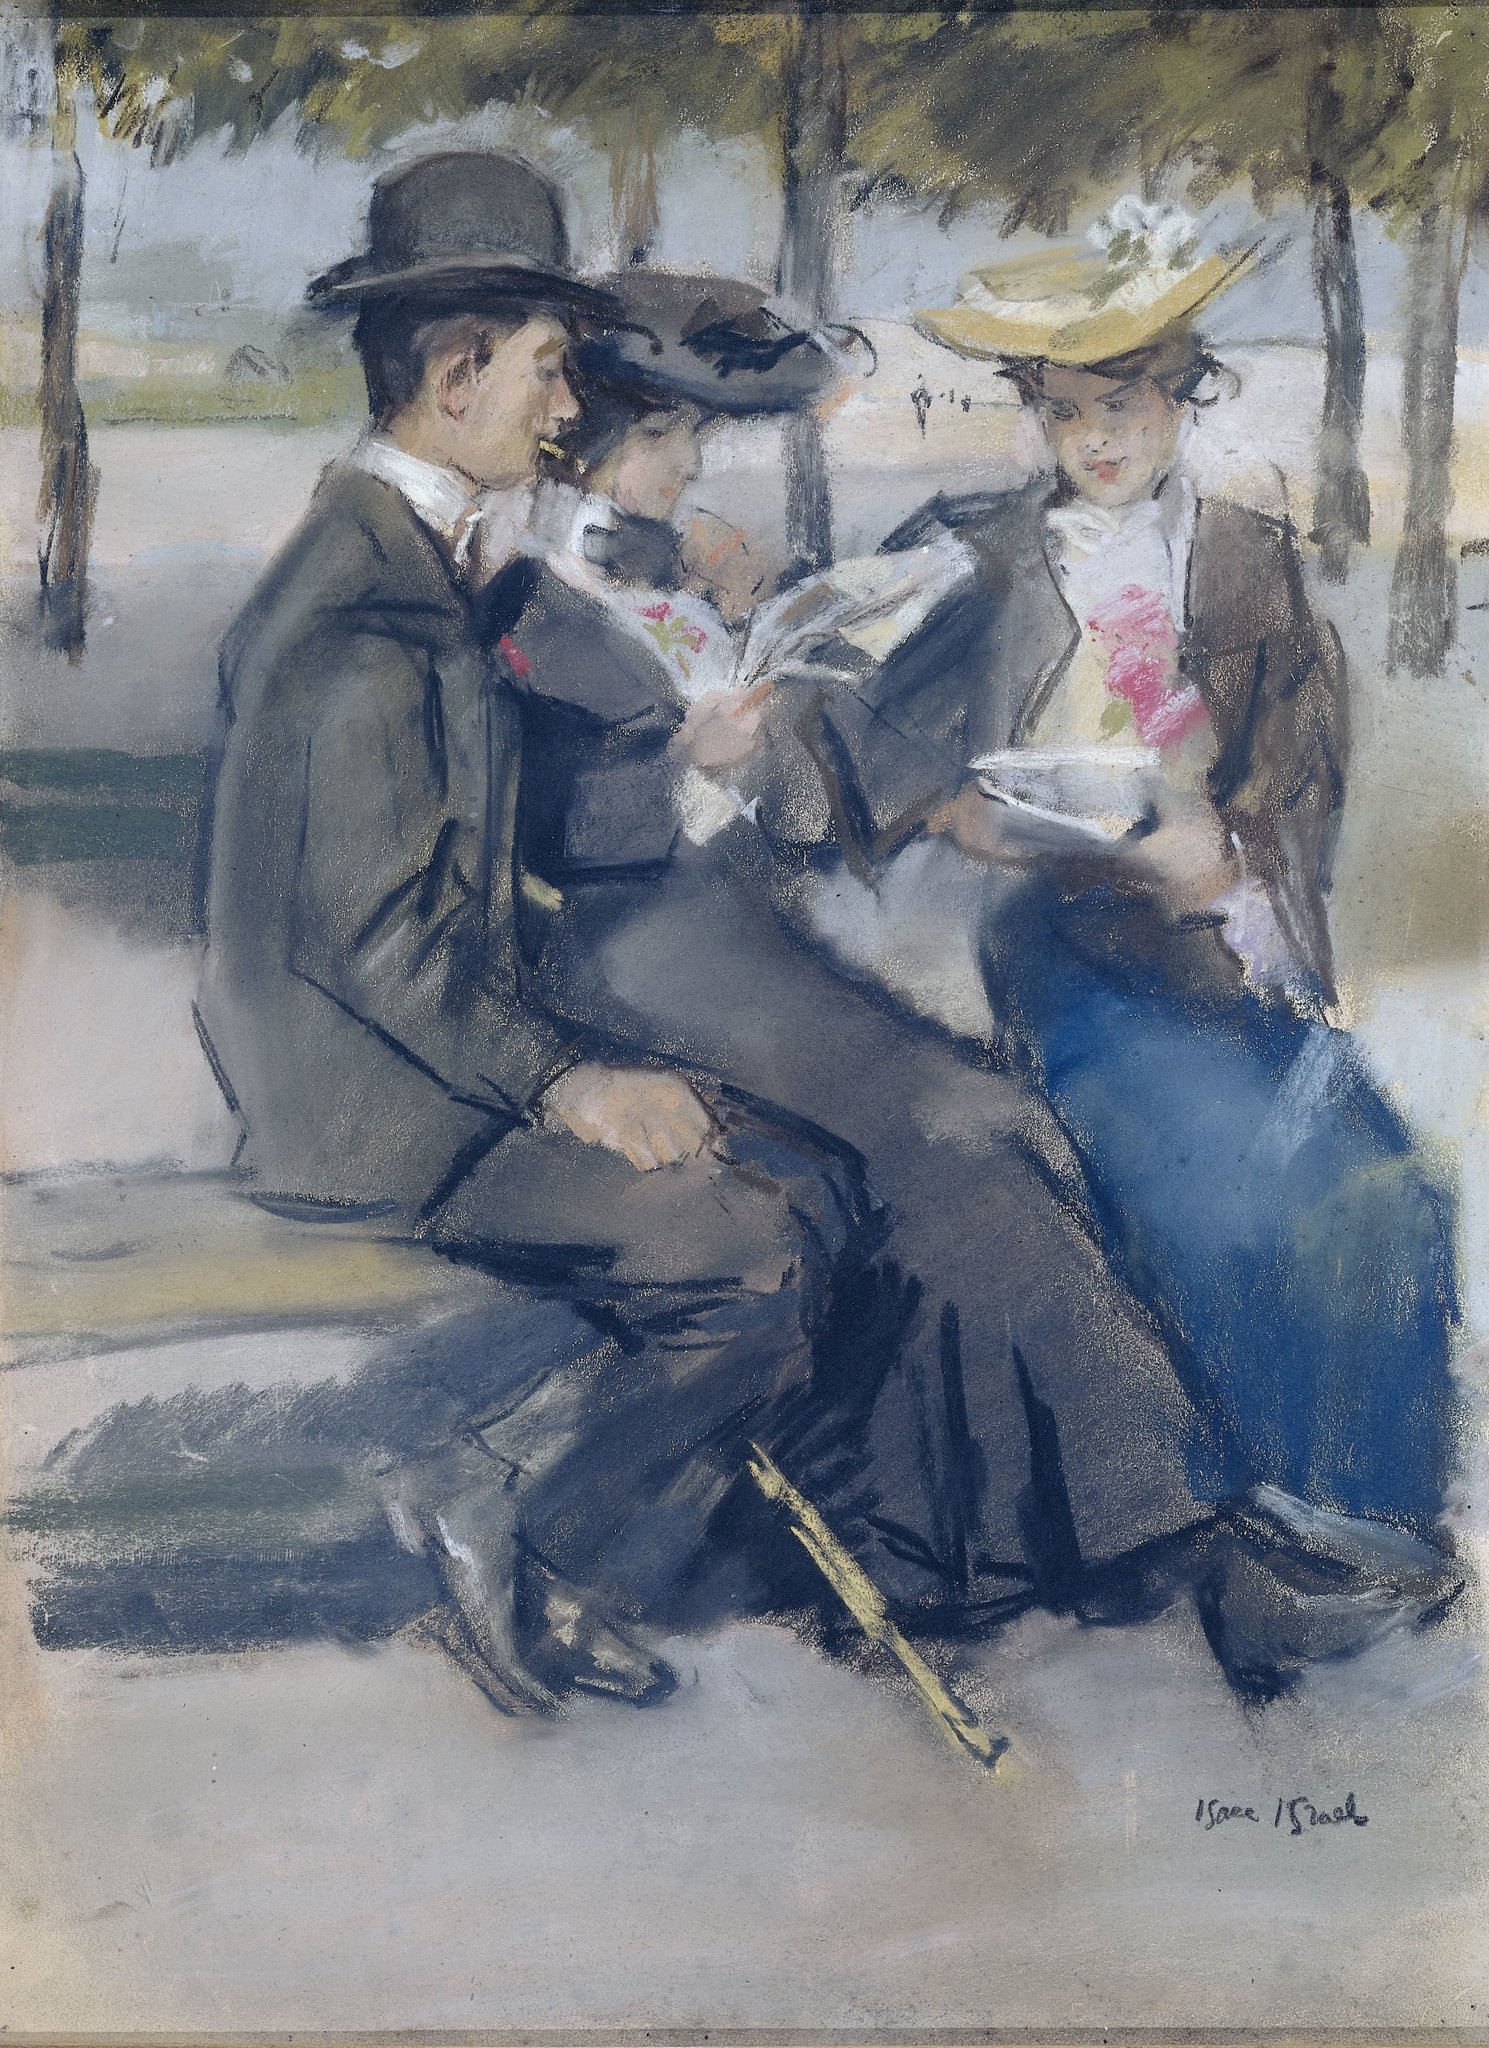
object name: drawing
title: In the Bois de Boulogne near Paris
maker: isaac israels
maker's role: draughtsman, painter, print maker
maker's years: 1865-1934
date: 1875-1919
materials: paper, pastel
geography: paris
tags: public gardens, park